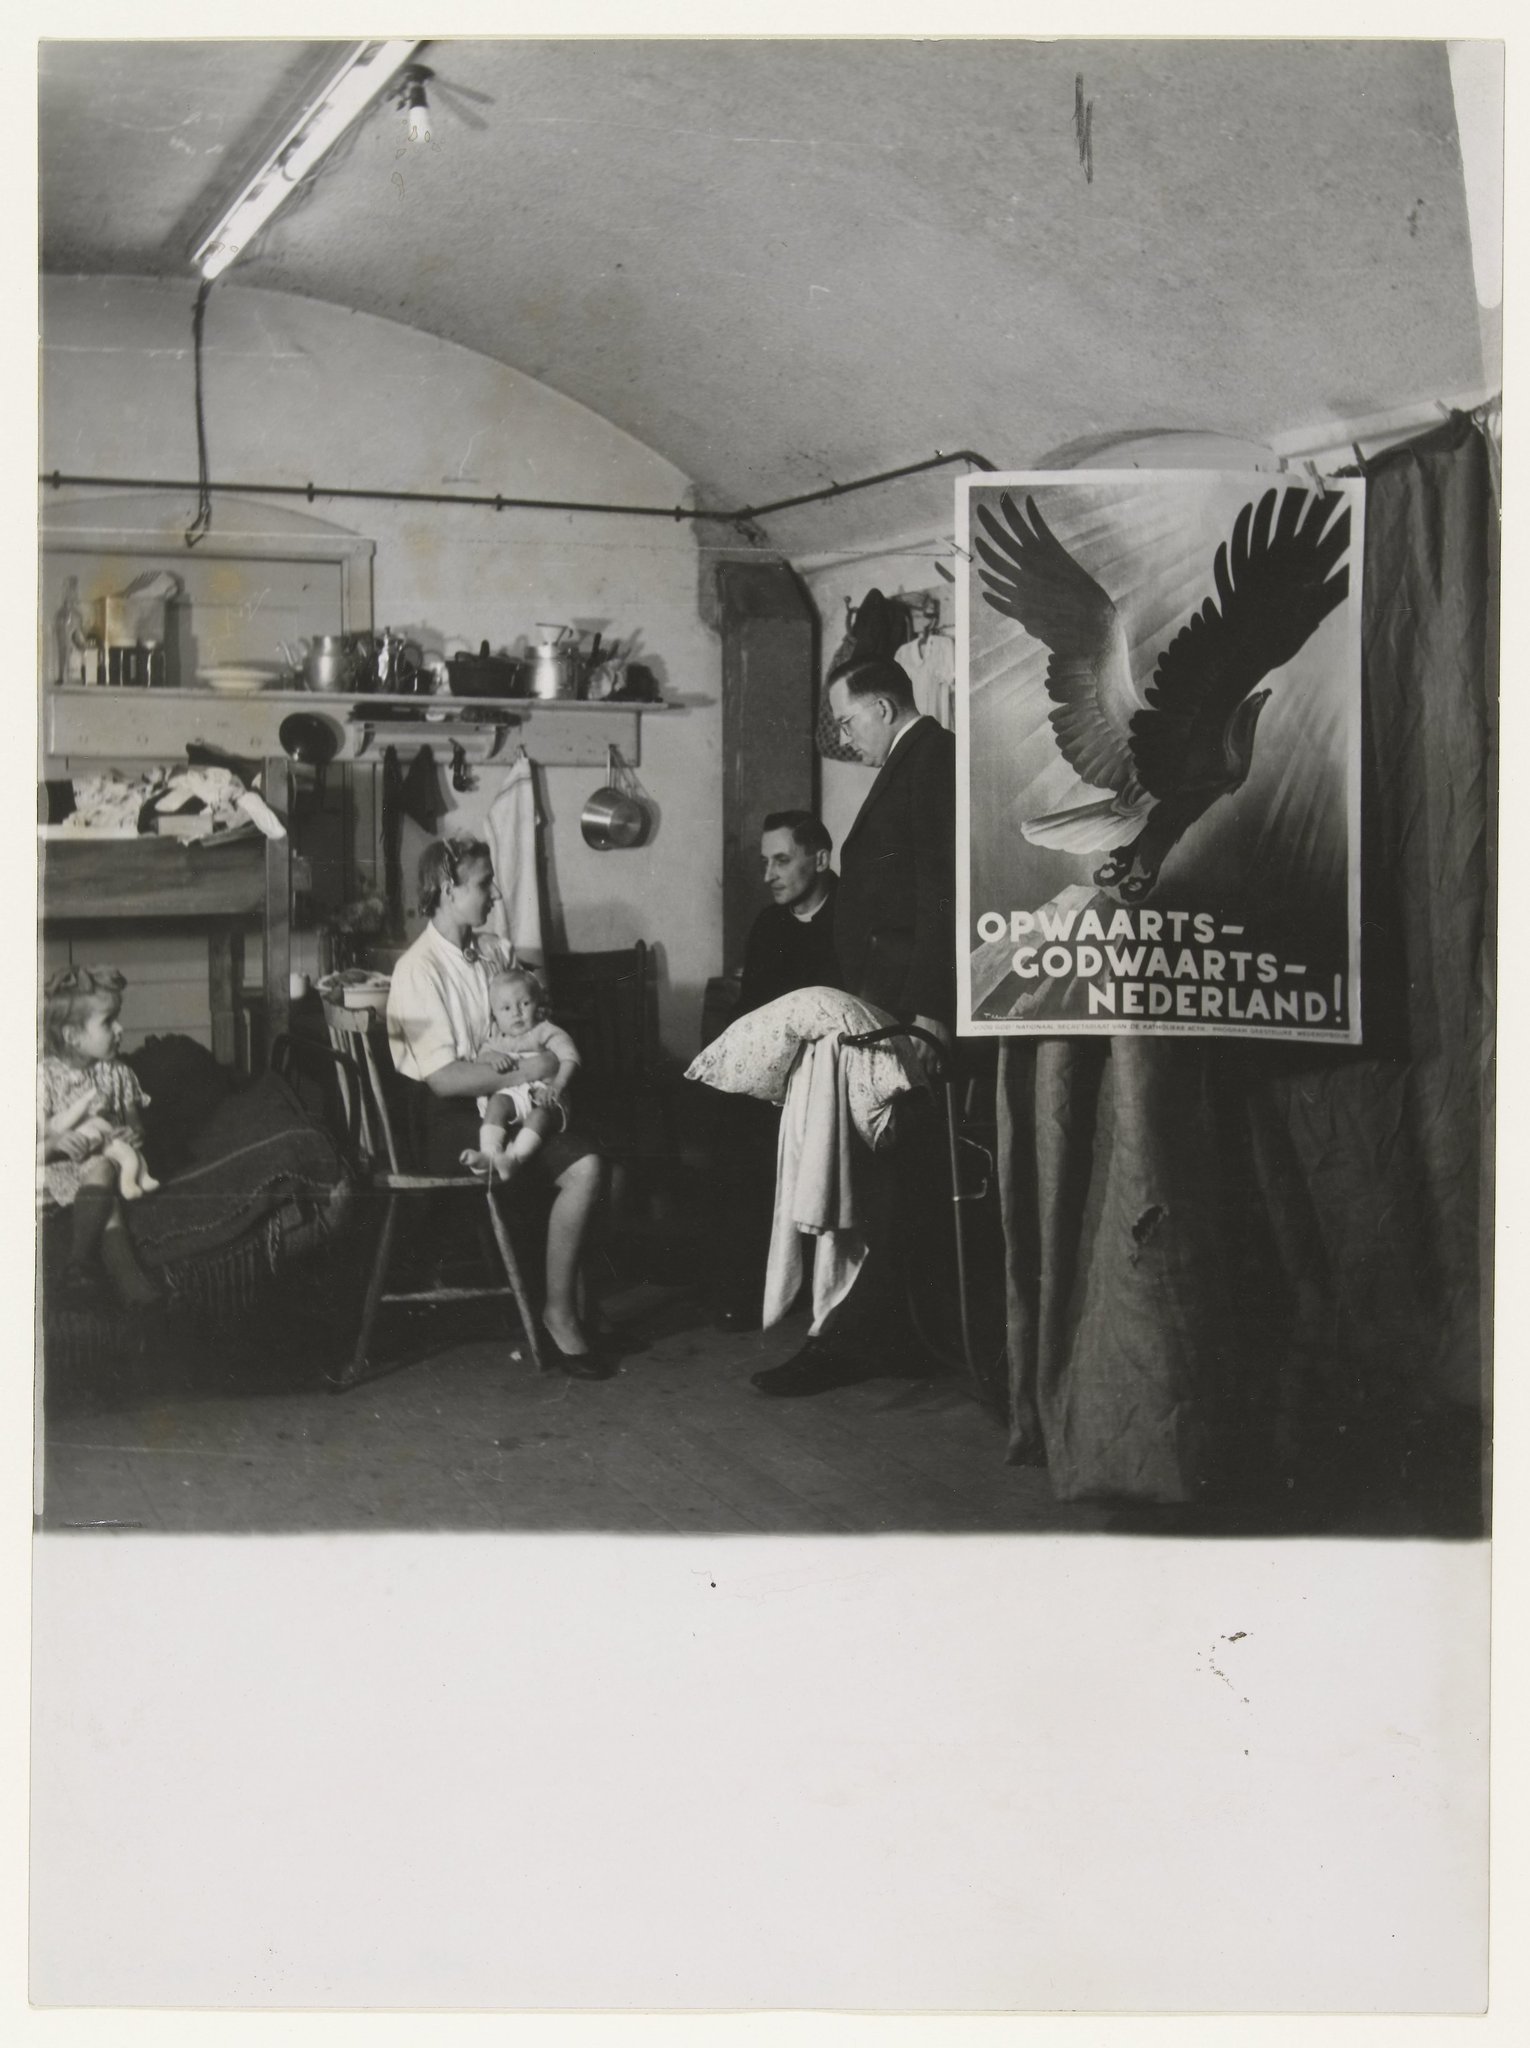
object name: documentary photograph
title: Gezin met kinderen in tijdelijke behuizing in een bunker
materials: photographic support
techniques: photography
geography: nijmegen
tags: nijmegen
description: Moeder met kind op schoot, kleuter en twee mannen zittend in de noodgedwongen tijdelijke woonkamer in een bunker met prominent in beeld een affiche met de tekst: Opwaarts-Godwaarts-Nederland!